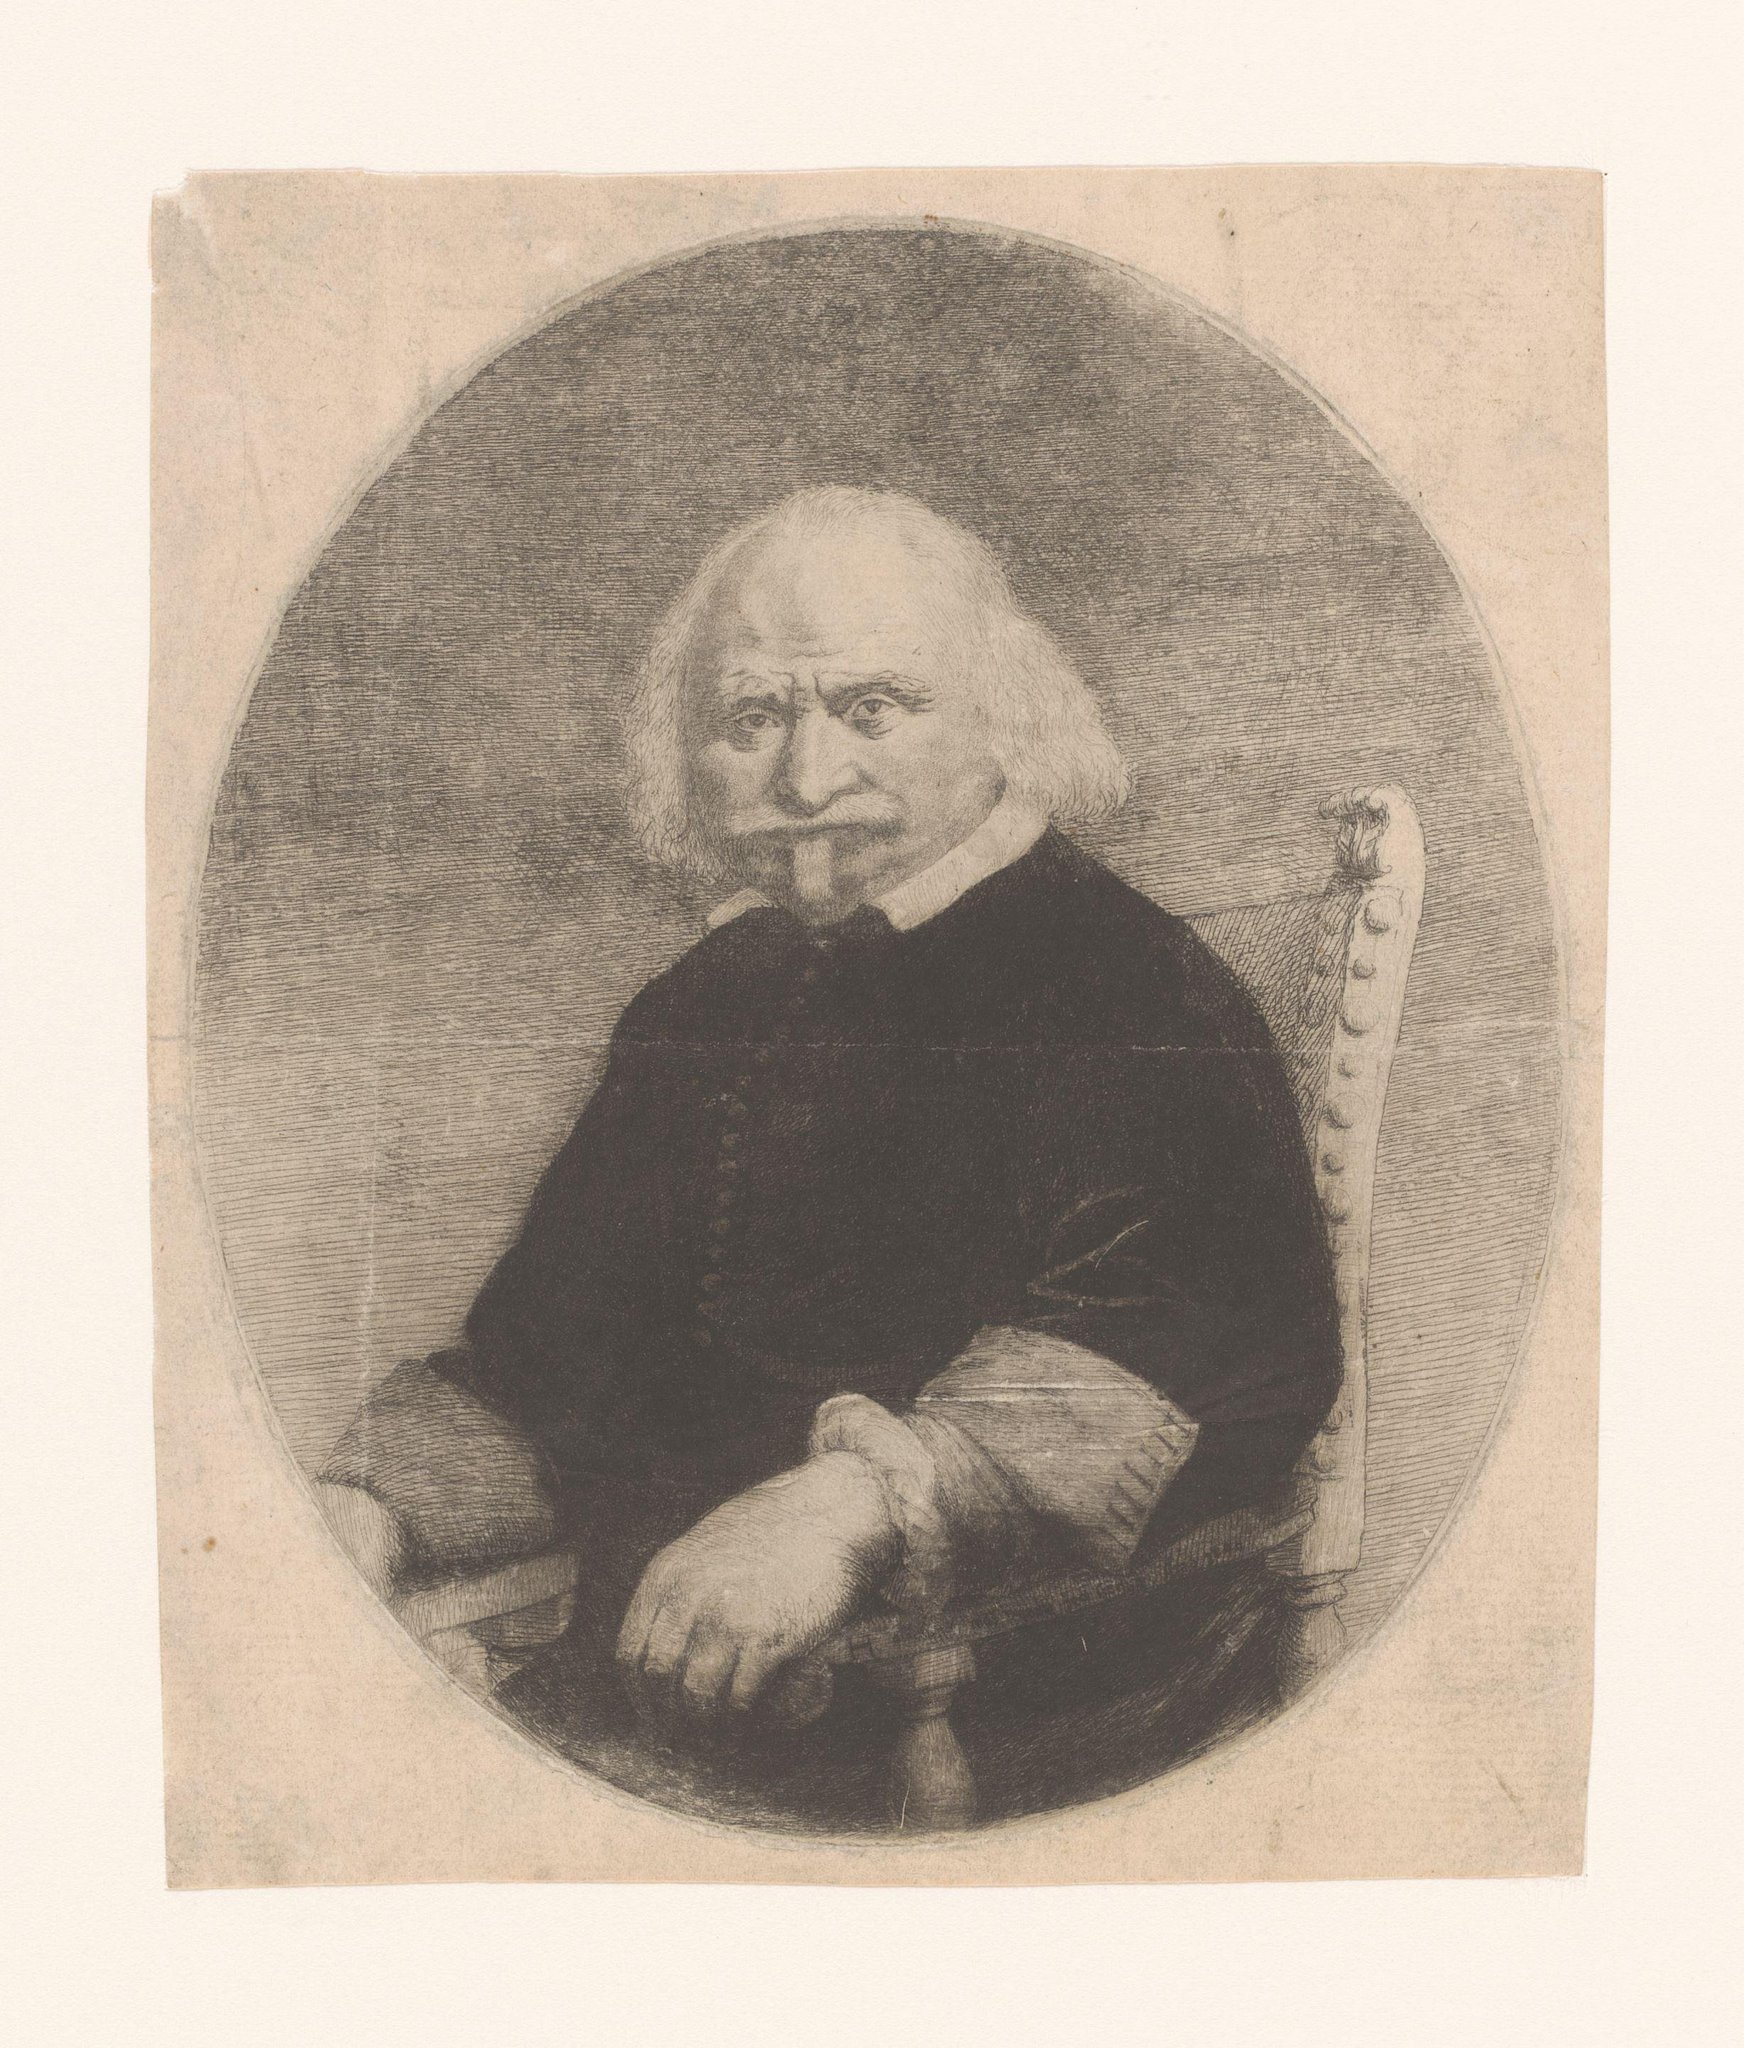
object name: print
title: Oude man in leunstoel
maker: hendrik oldelandt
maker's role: print maker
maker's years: 1613-1656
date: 1640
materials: paper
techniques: drypoint, etching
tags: old man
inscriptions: collector's mark: Lugt 240